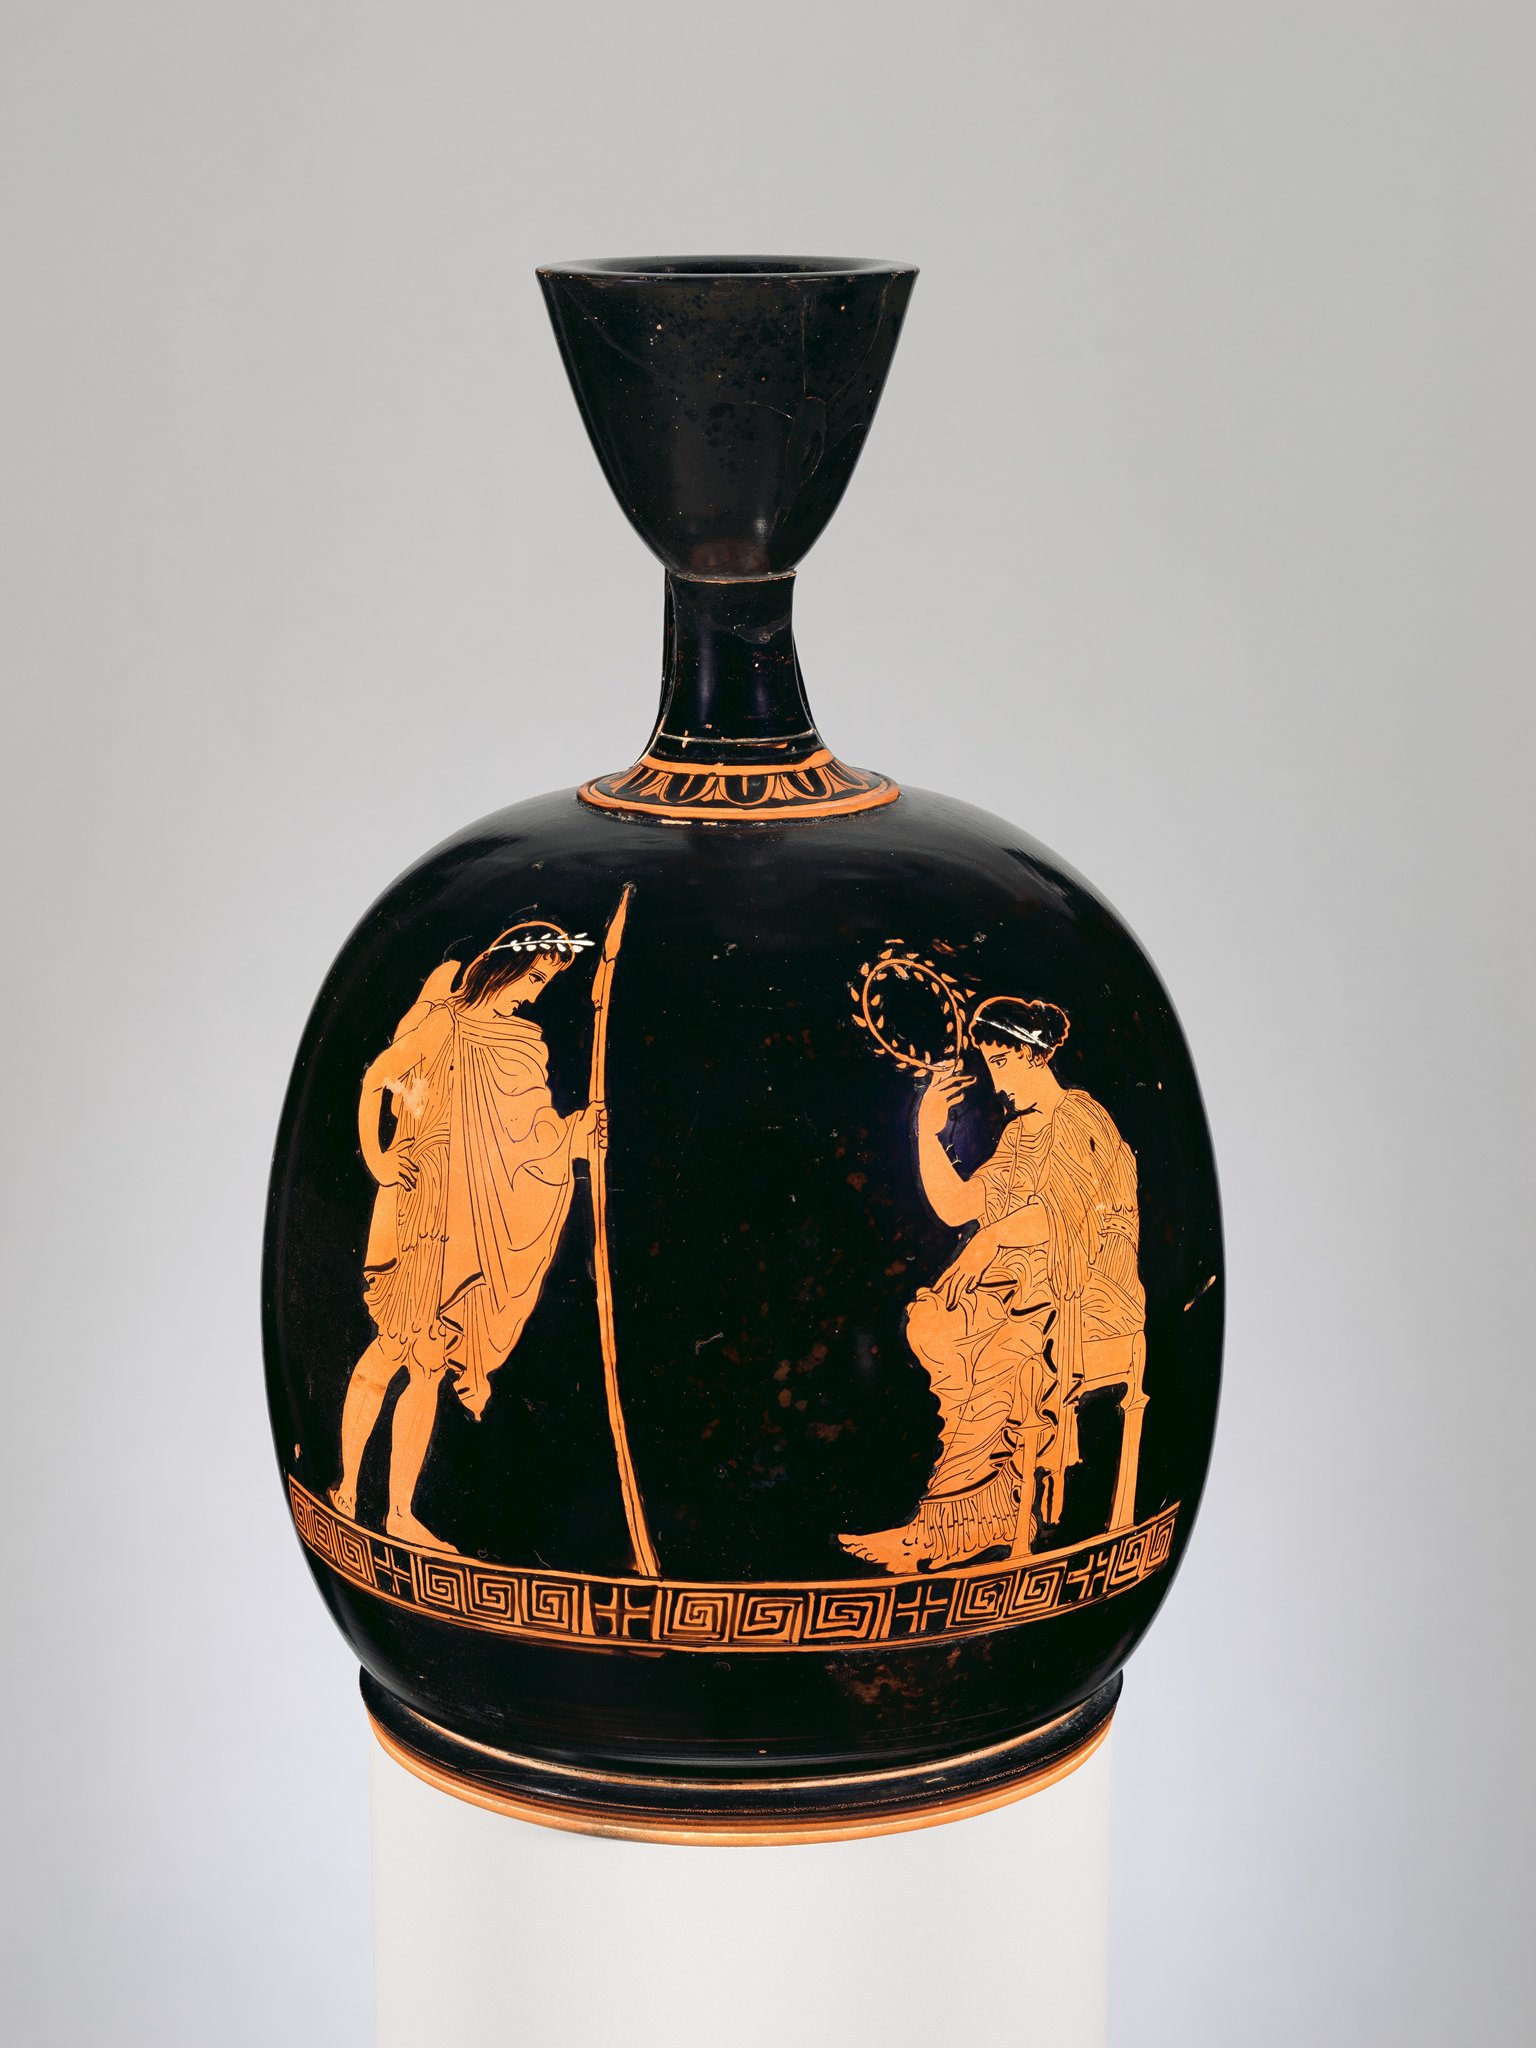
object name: squat lekythos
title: Terracotta squat lekythos (oil flask)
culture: greek, attic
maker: washing painter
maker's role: artist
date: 430-420 BCE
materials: terracotta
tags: men,women,wreaths